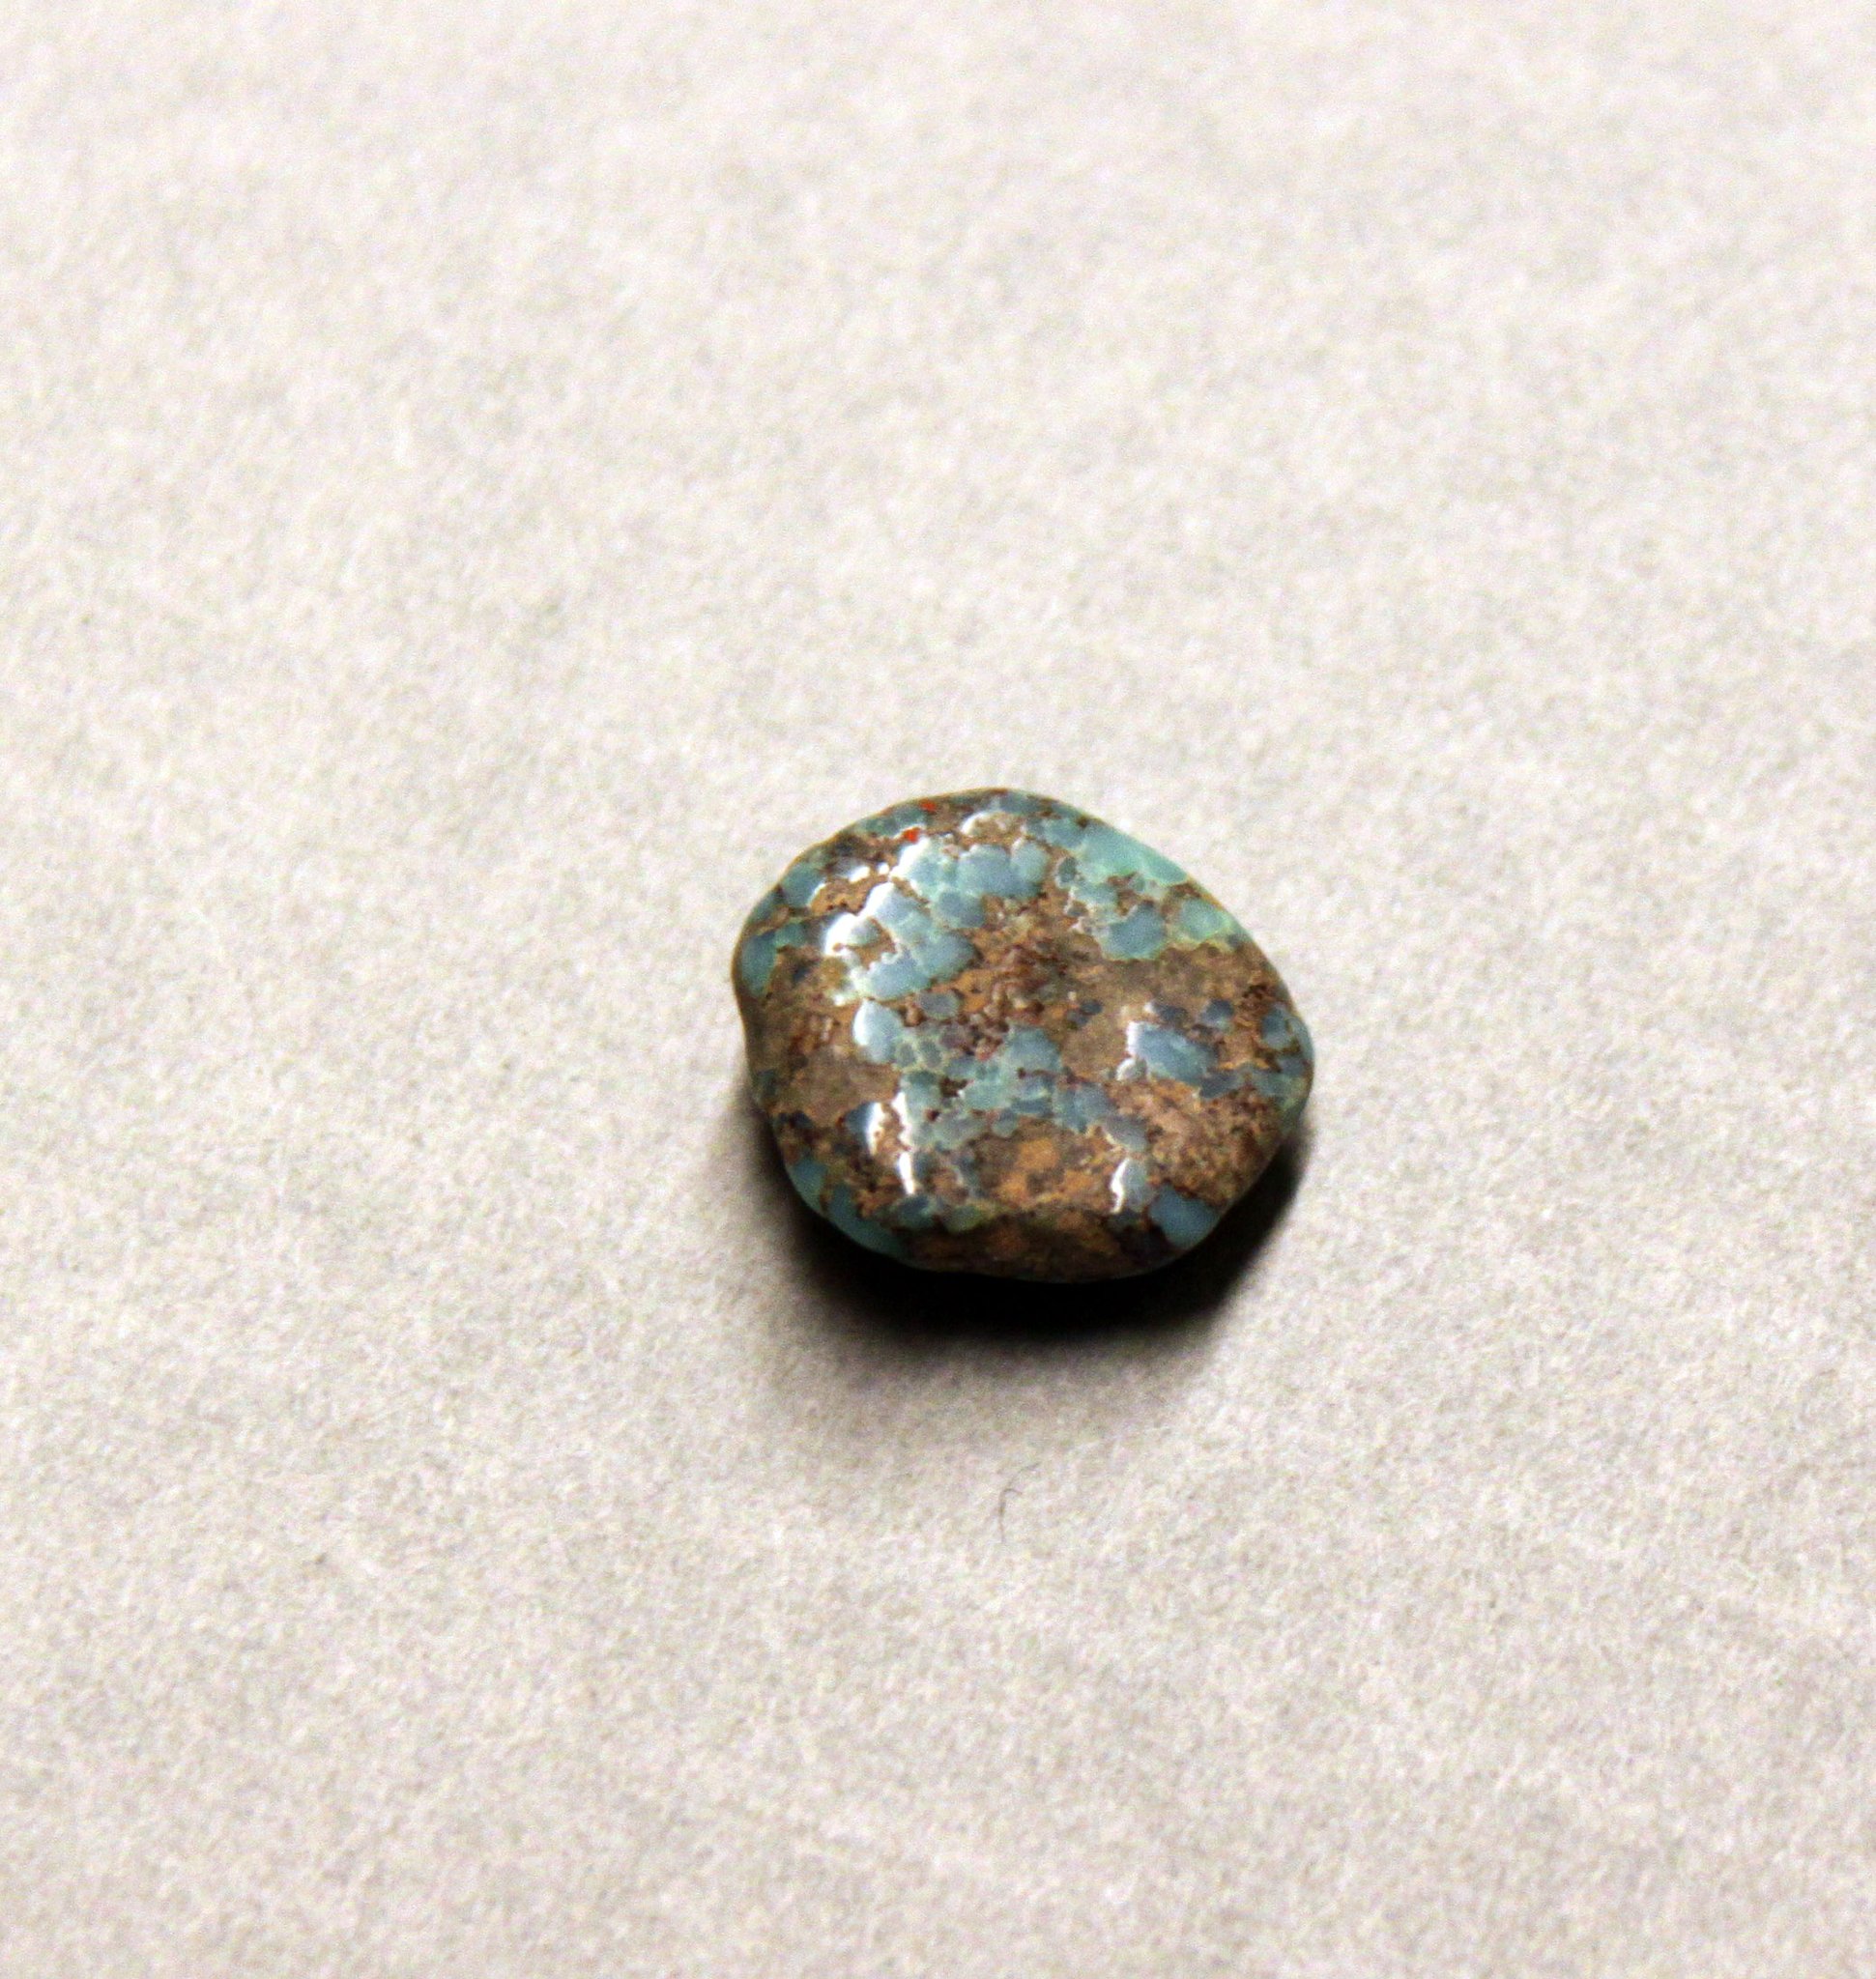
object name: stone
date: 701-1200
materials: stone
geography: iran